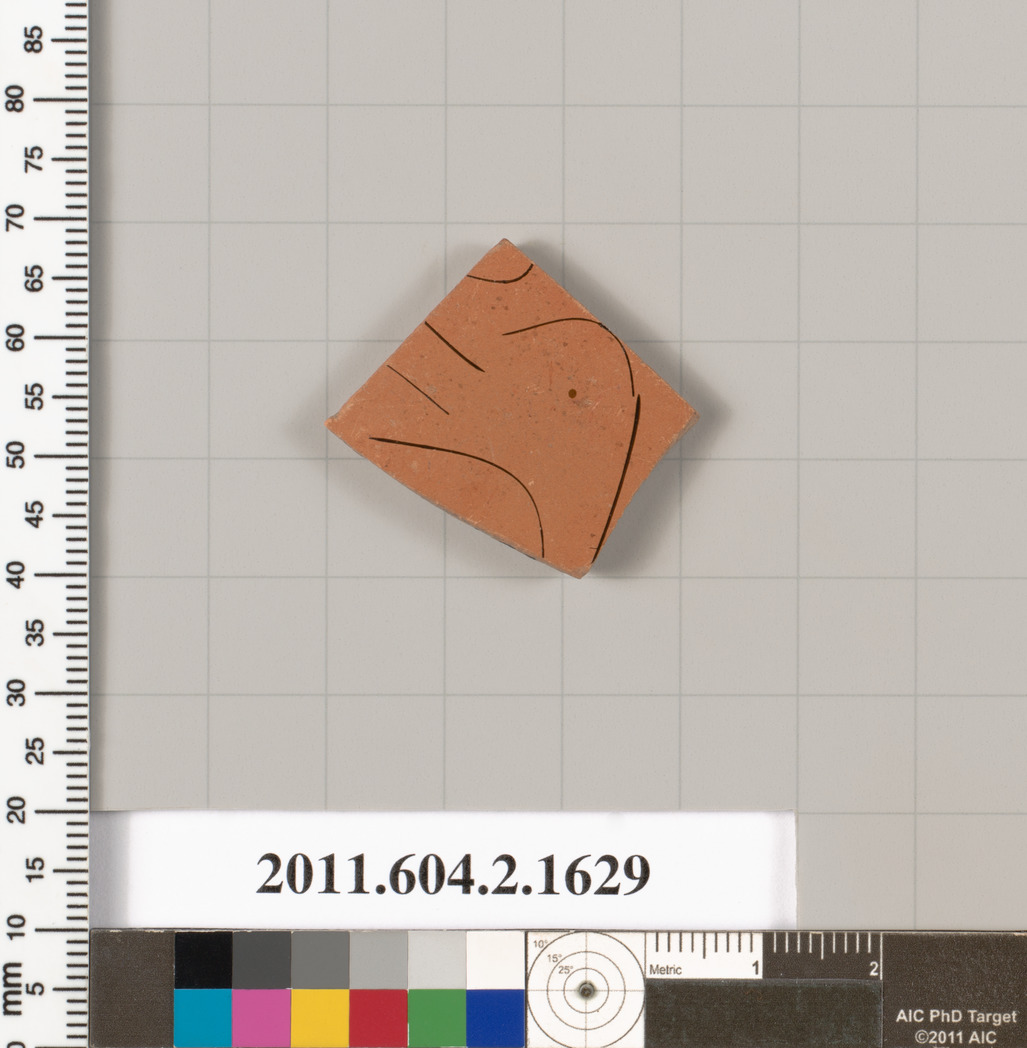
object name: skyphos fragment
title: Terracotta fragment of a skyphos (deep drinking cup)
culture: greek, attic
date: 425-401 BCE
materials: terracotta